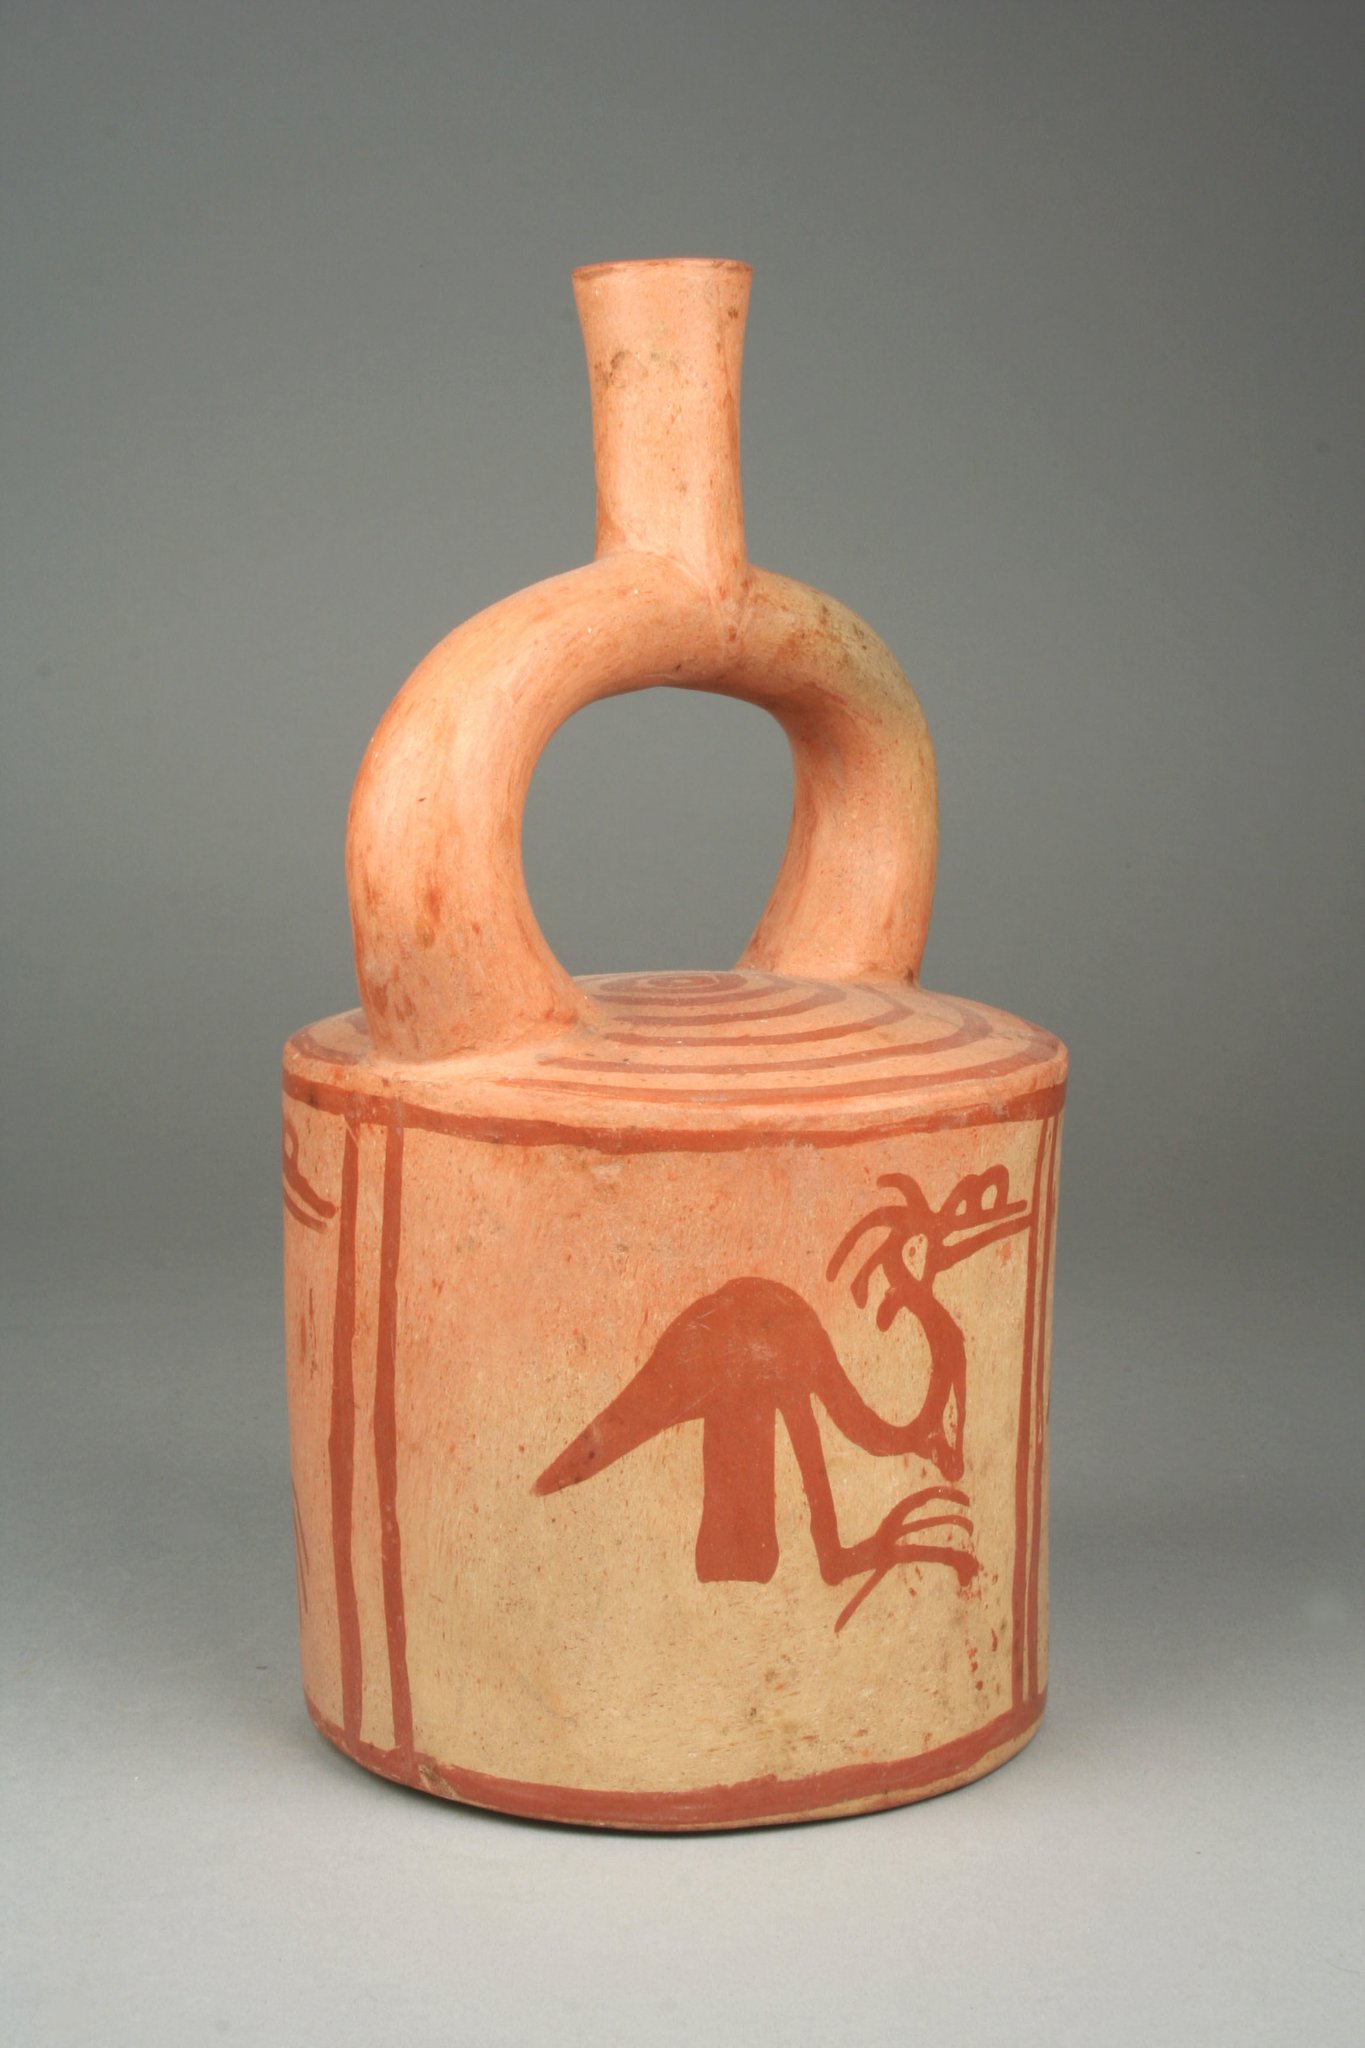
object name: bottle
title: Stirrup Spout Bottle with Long Necked Birds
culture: moche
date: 1-600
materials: ceramic, pigment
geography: peru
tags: birds